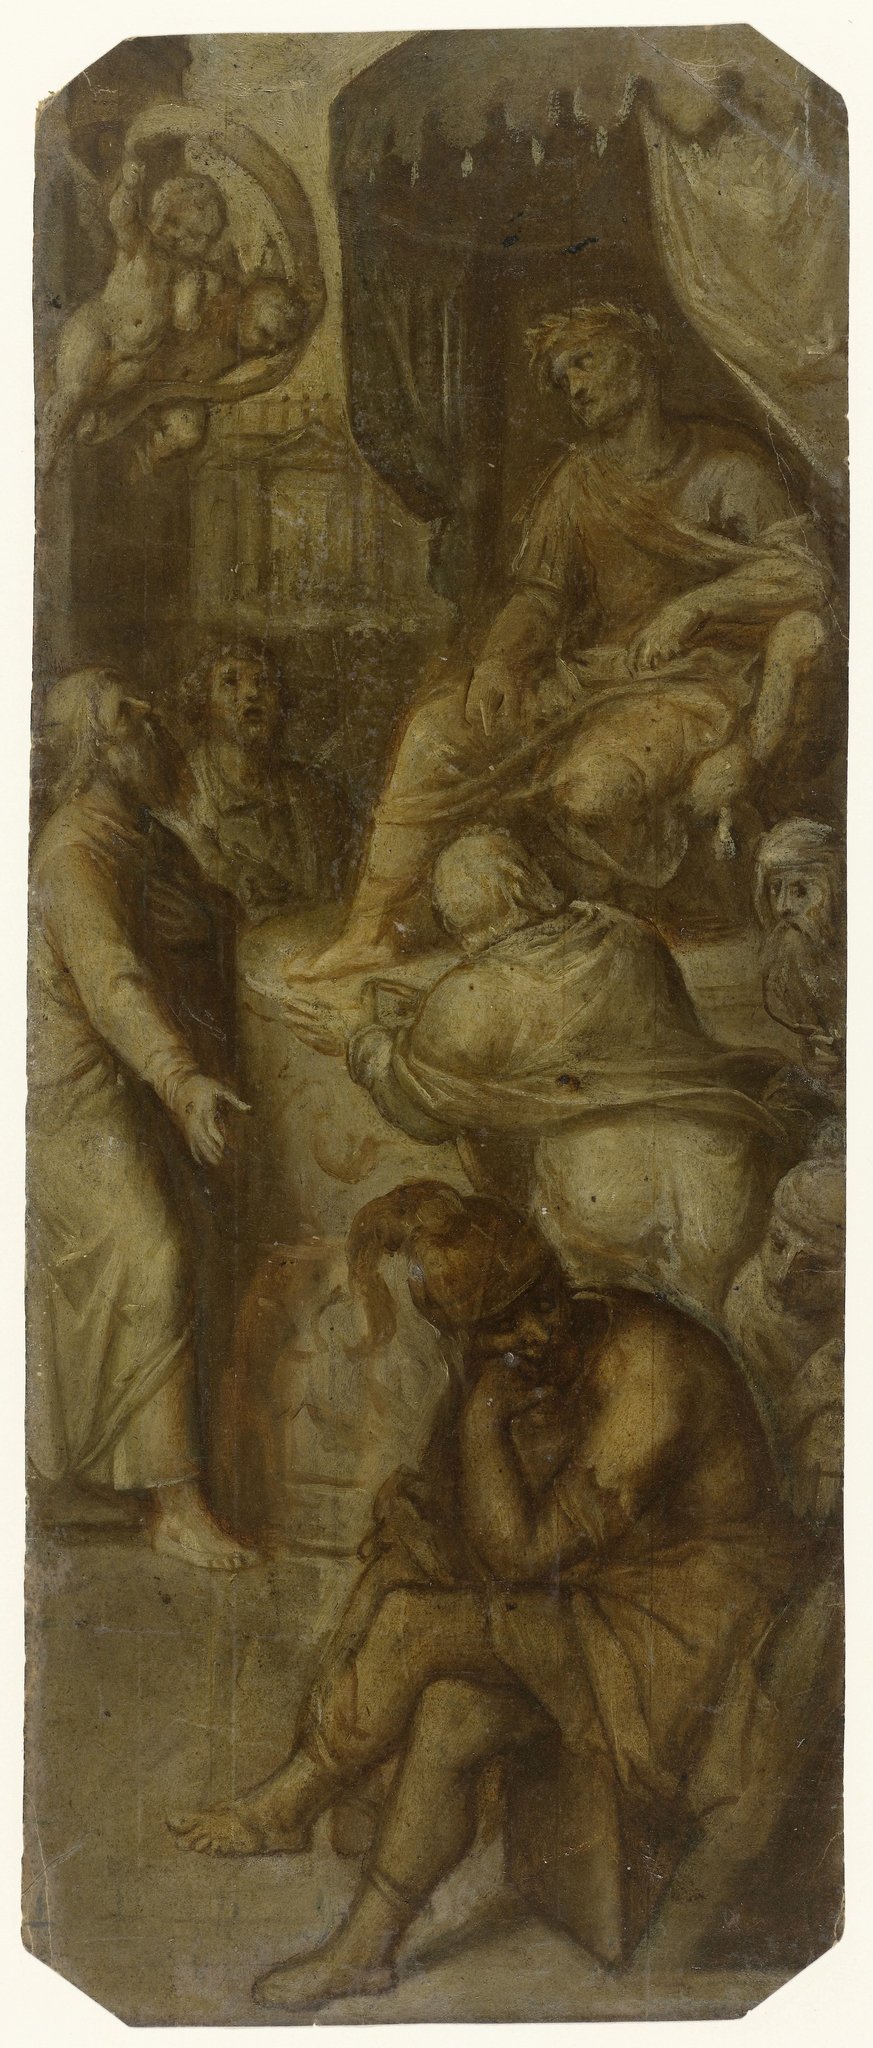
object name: design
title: Paulus voor de magistraat van Caesarea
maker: otto van veen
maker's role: draughtsman, painter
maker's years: 1556-1629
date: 1600-1610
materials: oil, paper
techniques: grisaille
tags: paul is brought to caesarea by soldiers with a letter to felix, the governor